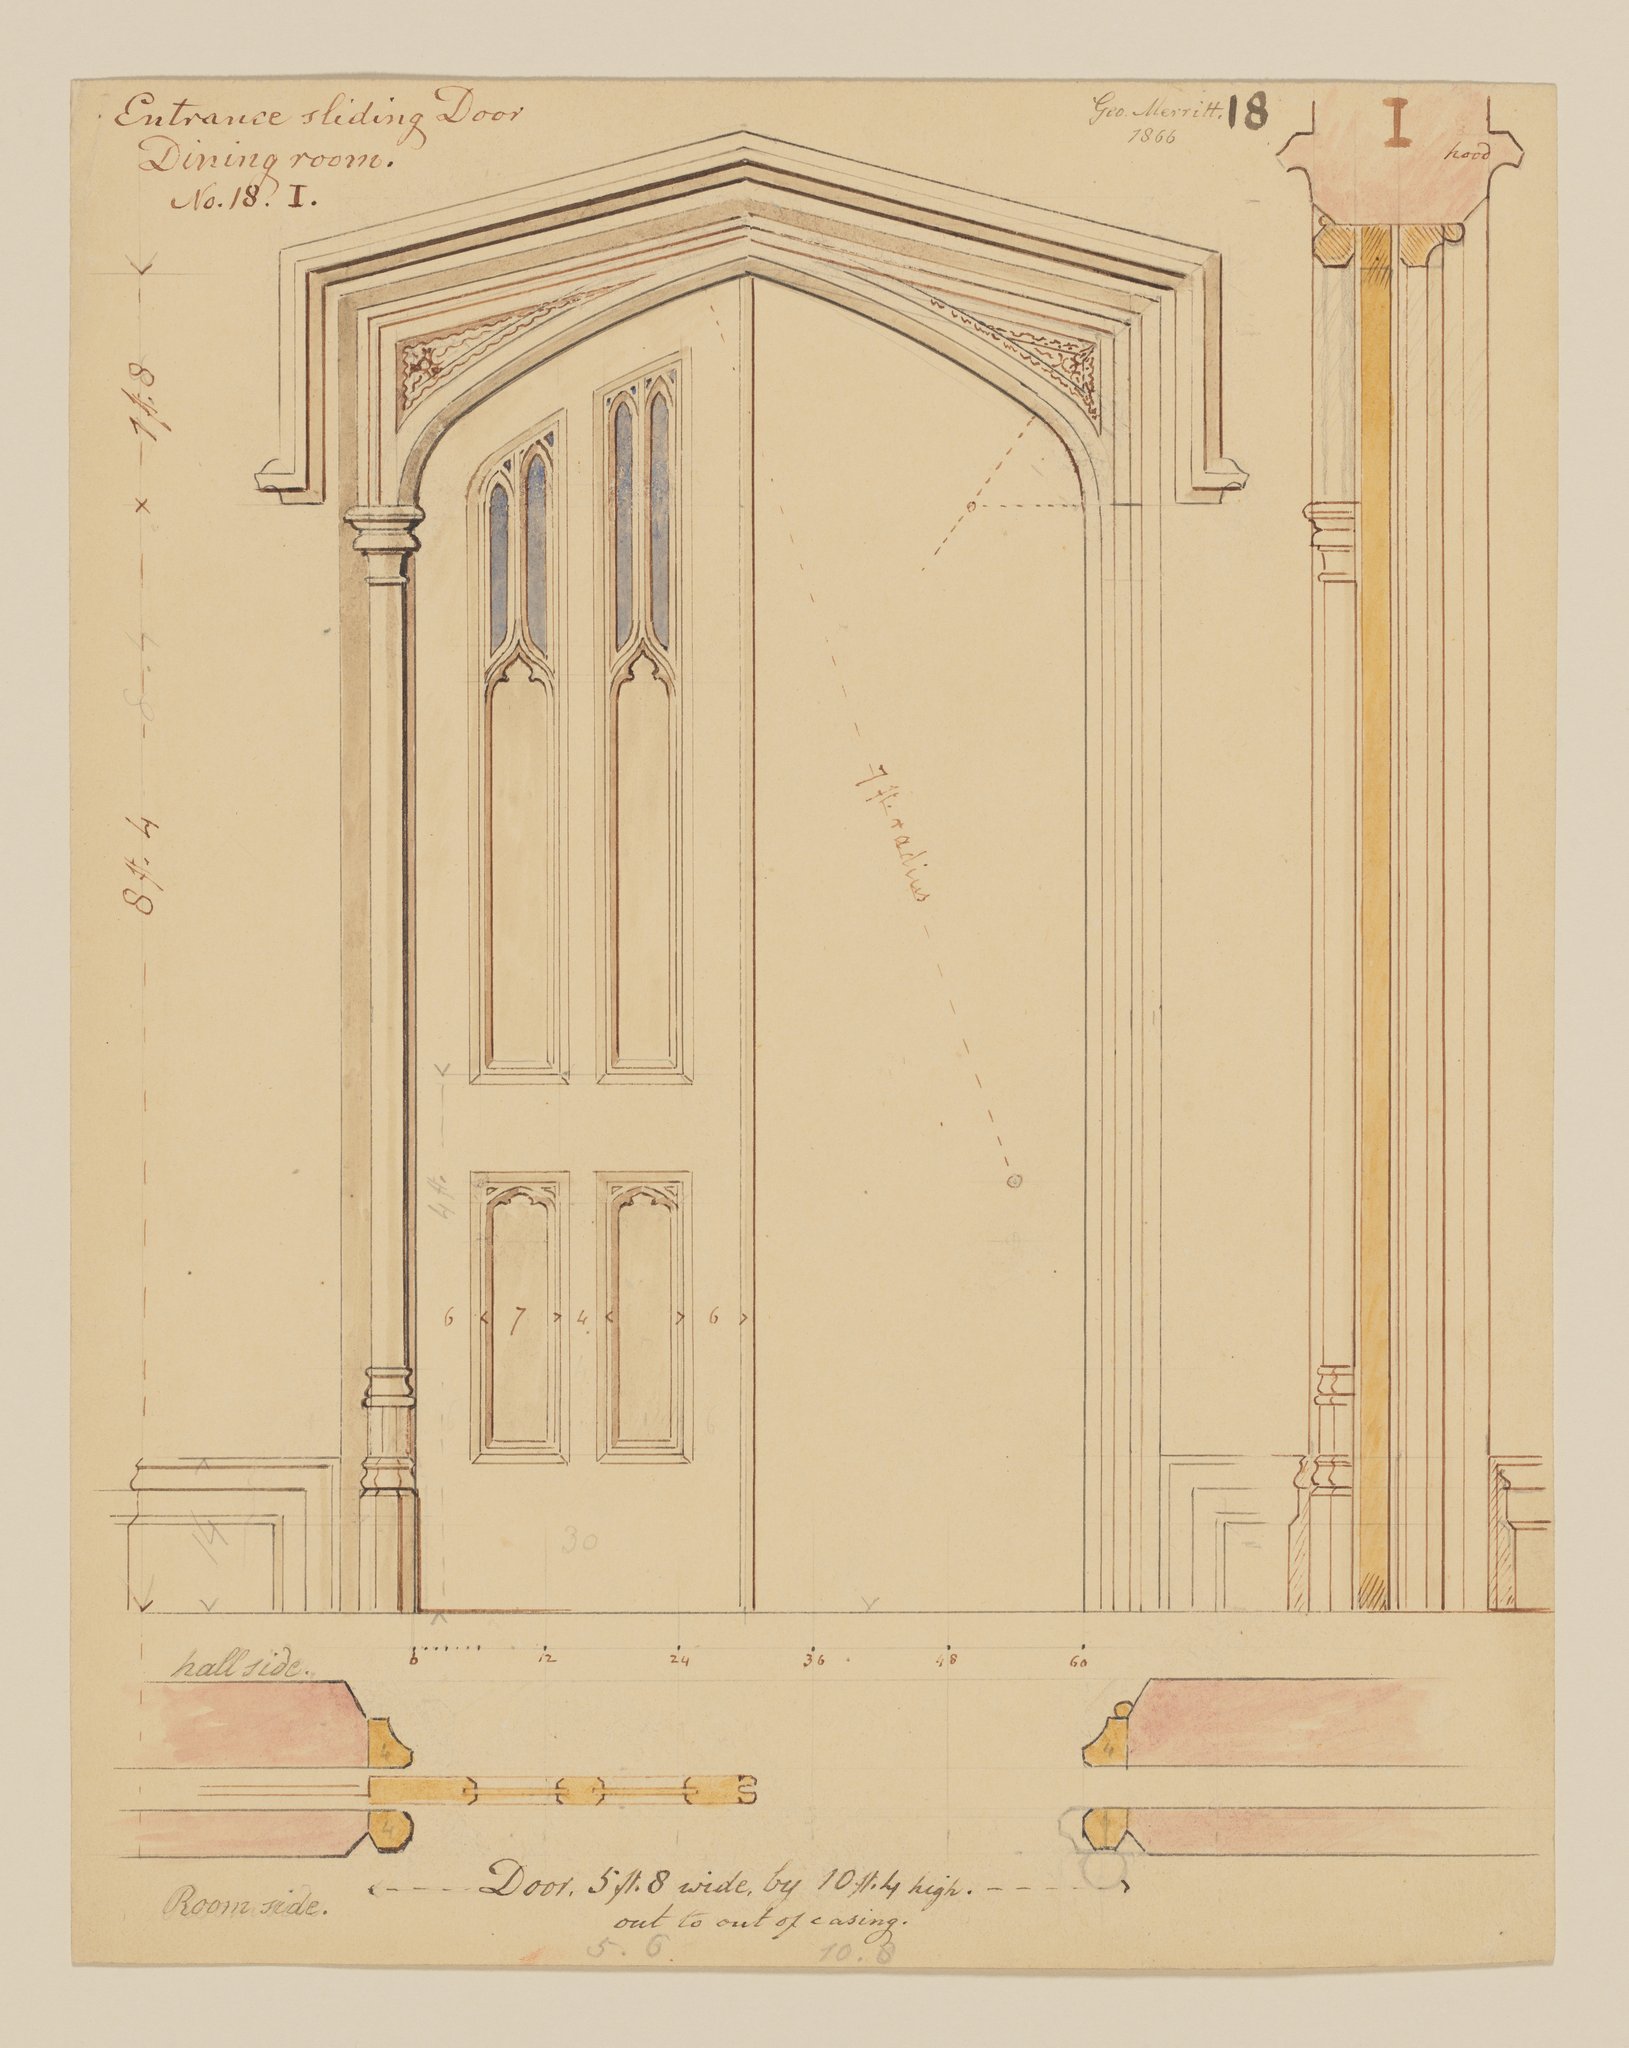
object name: drawing ornament architecture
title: Technical Drawing of the Sliding Door for the Dining Room at Lyndhurst for George Merritt, Tarrytown, New York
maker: alexander jackson davis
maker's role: artist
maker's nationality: american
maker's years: 1803-1892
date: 1866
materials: graphite, ink, watercolor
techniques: pen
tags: doors